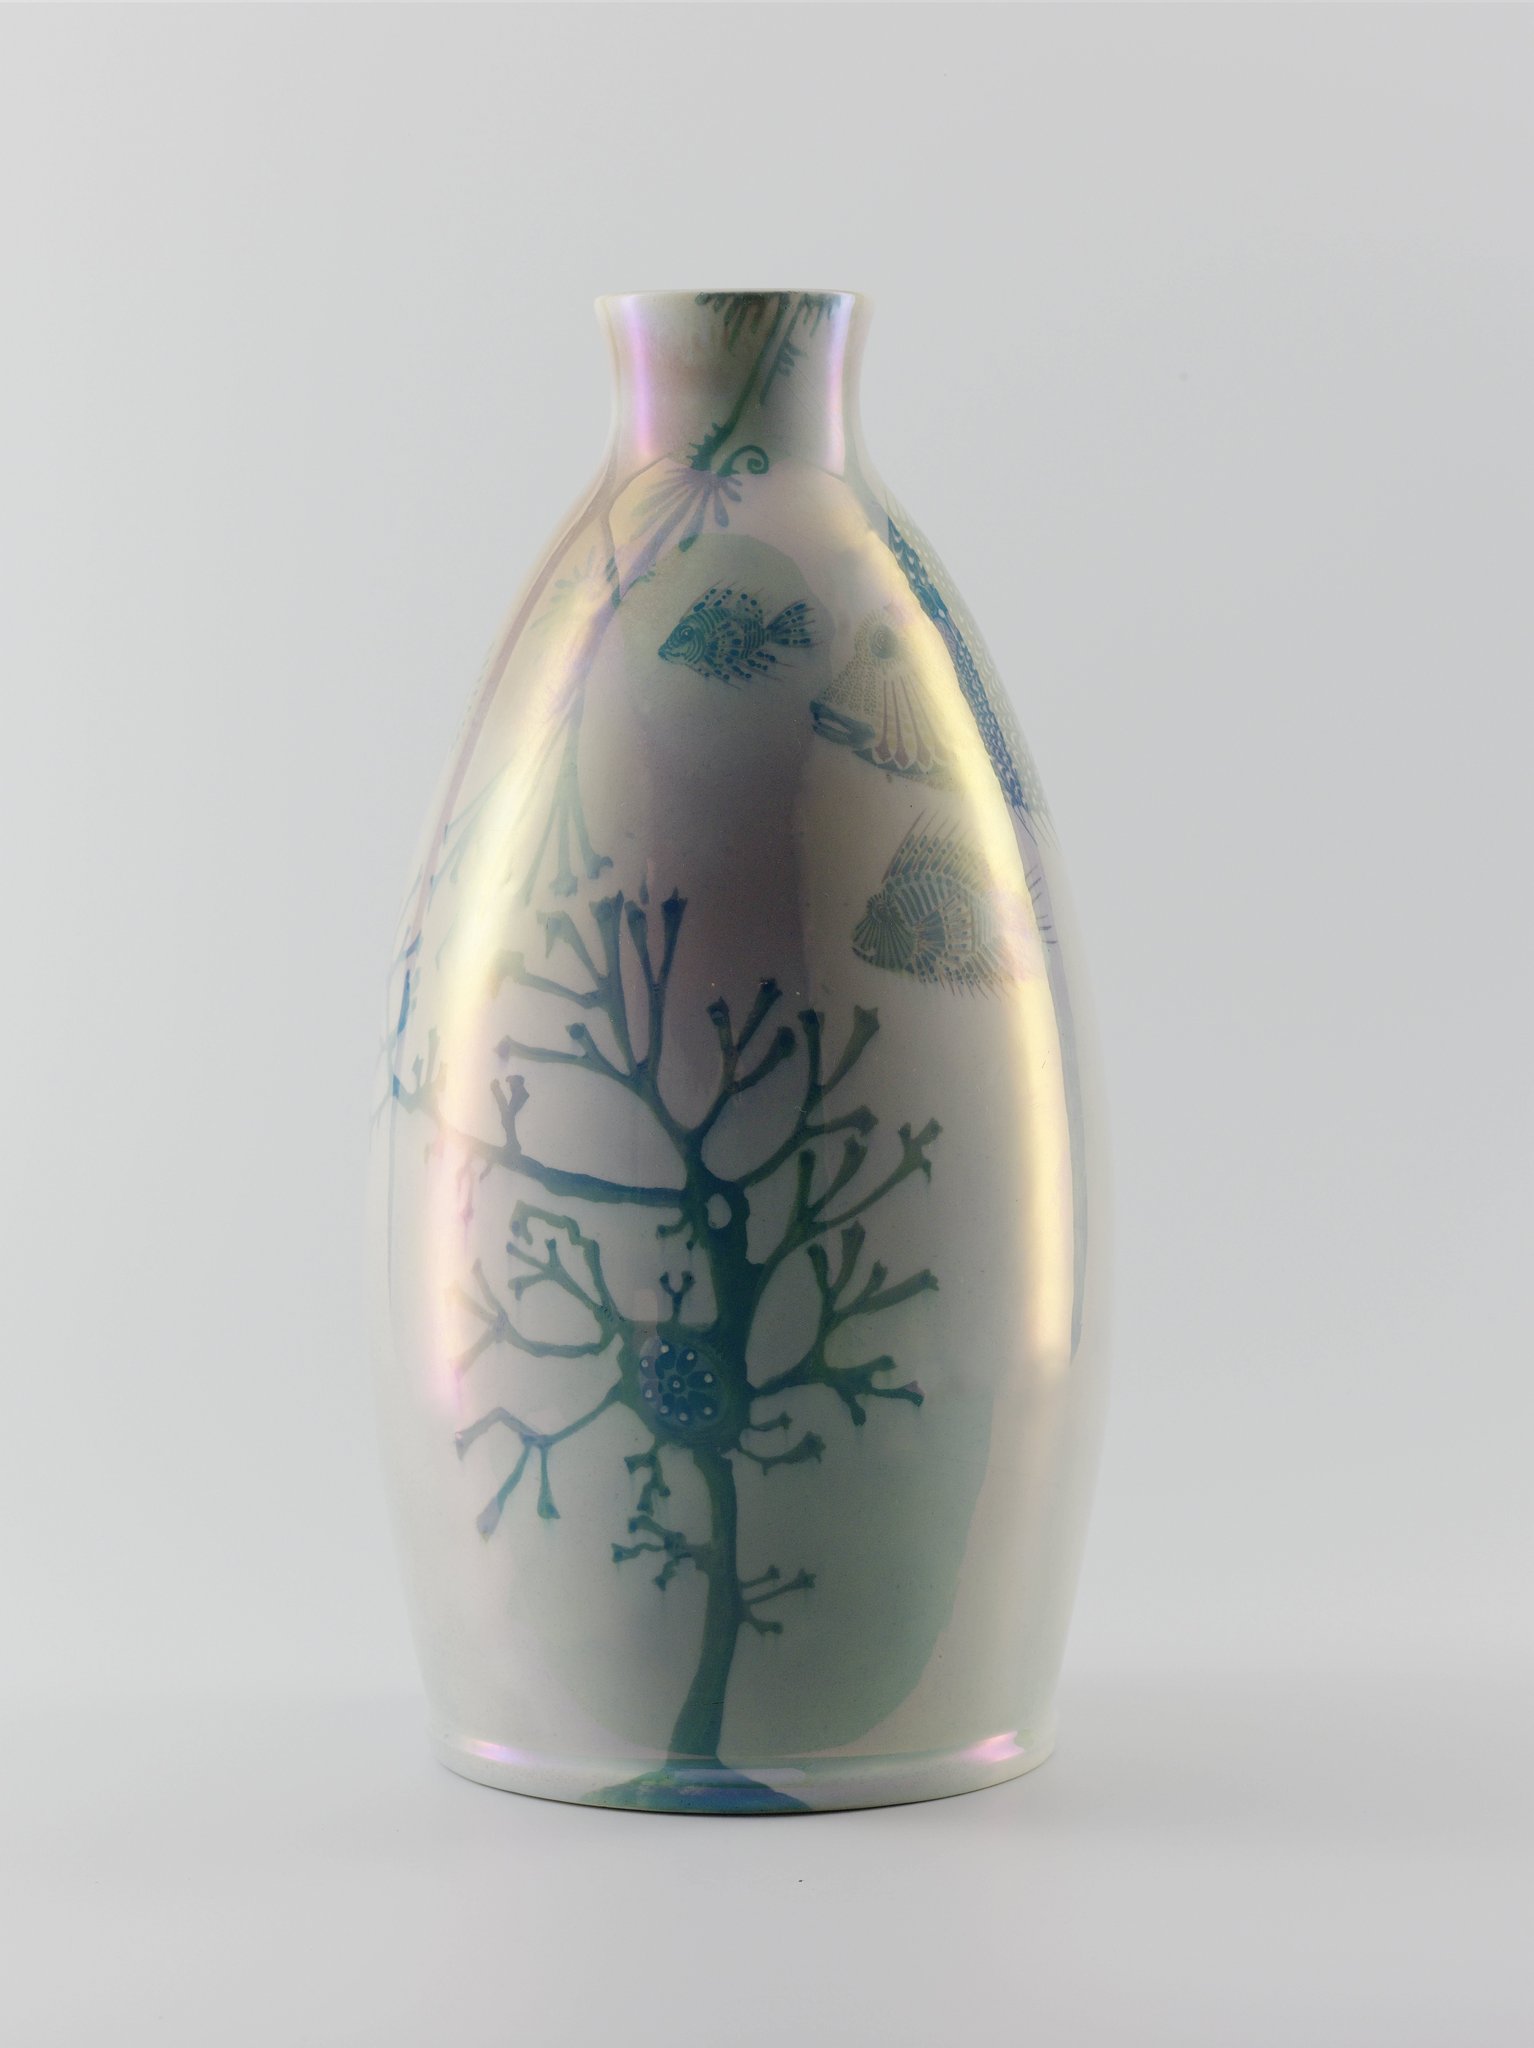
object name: vase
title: Vaas, beschilderd met vissen, planten en wier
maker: chris lanooy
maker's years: 1881-1948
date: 1904-1907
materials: earthenware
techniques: painted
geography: purmerend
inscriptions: mark: ‘fabrieksstempel ; Mod: 18 ; een symbool ; Ø ; ontw: J.C. Lanooy’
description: Vaas, beschilderd met vissen, planten en wier in blauwgroen, paars en geel op een blauw fond met rode vlekken en bedekt met lusterglazuur.